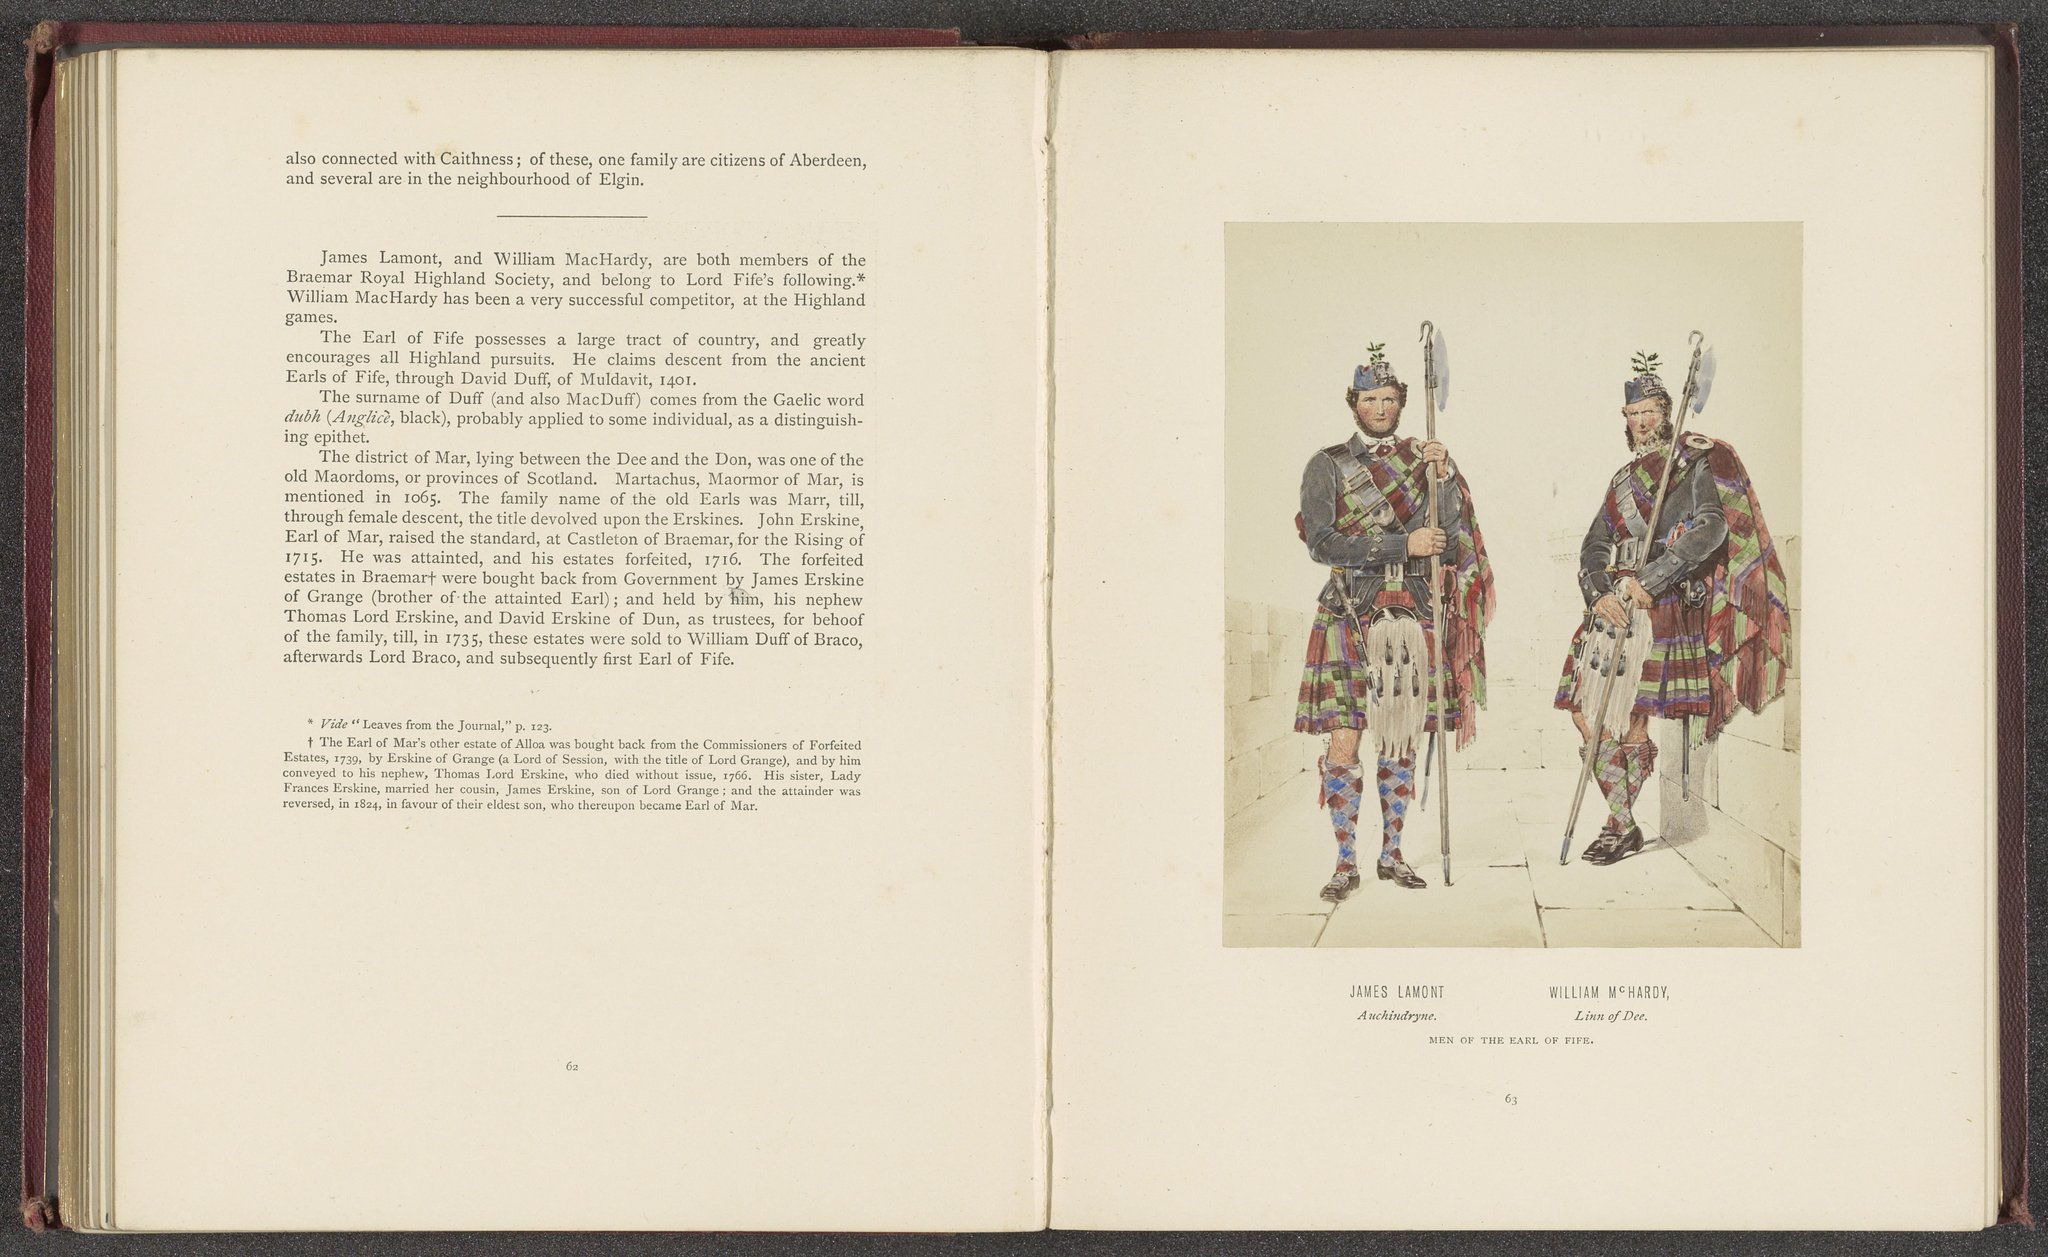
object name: page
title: Fotoreproductie van een tekening van portretten van James Lamont en William Mc Hardy, twee soldaten van de Earl of Fife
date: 1860-1870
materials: photographic support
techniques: albumen print, hand coloring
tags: private soldier, adult man, folk costume, regional costume